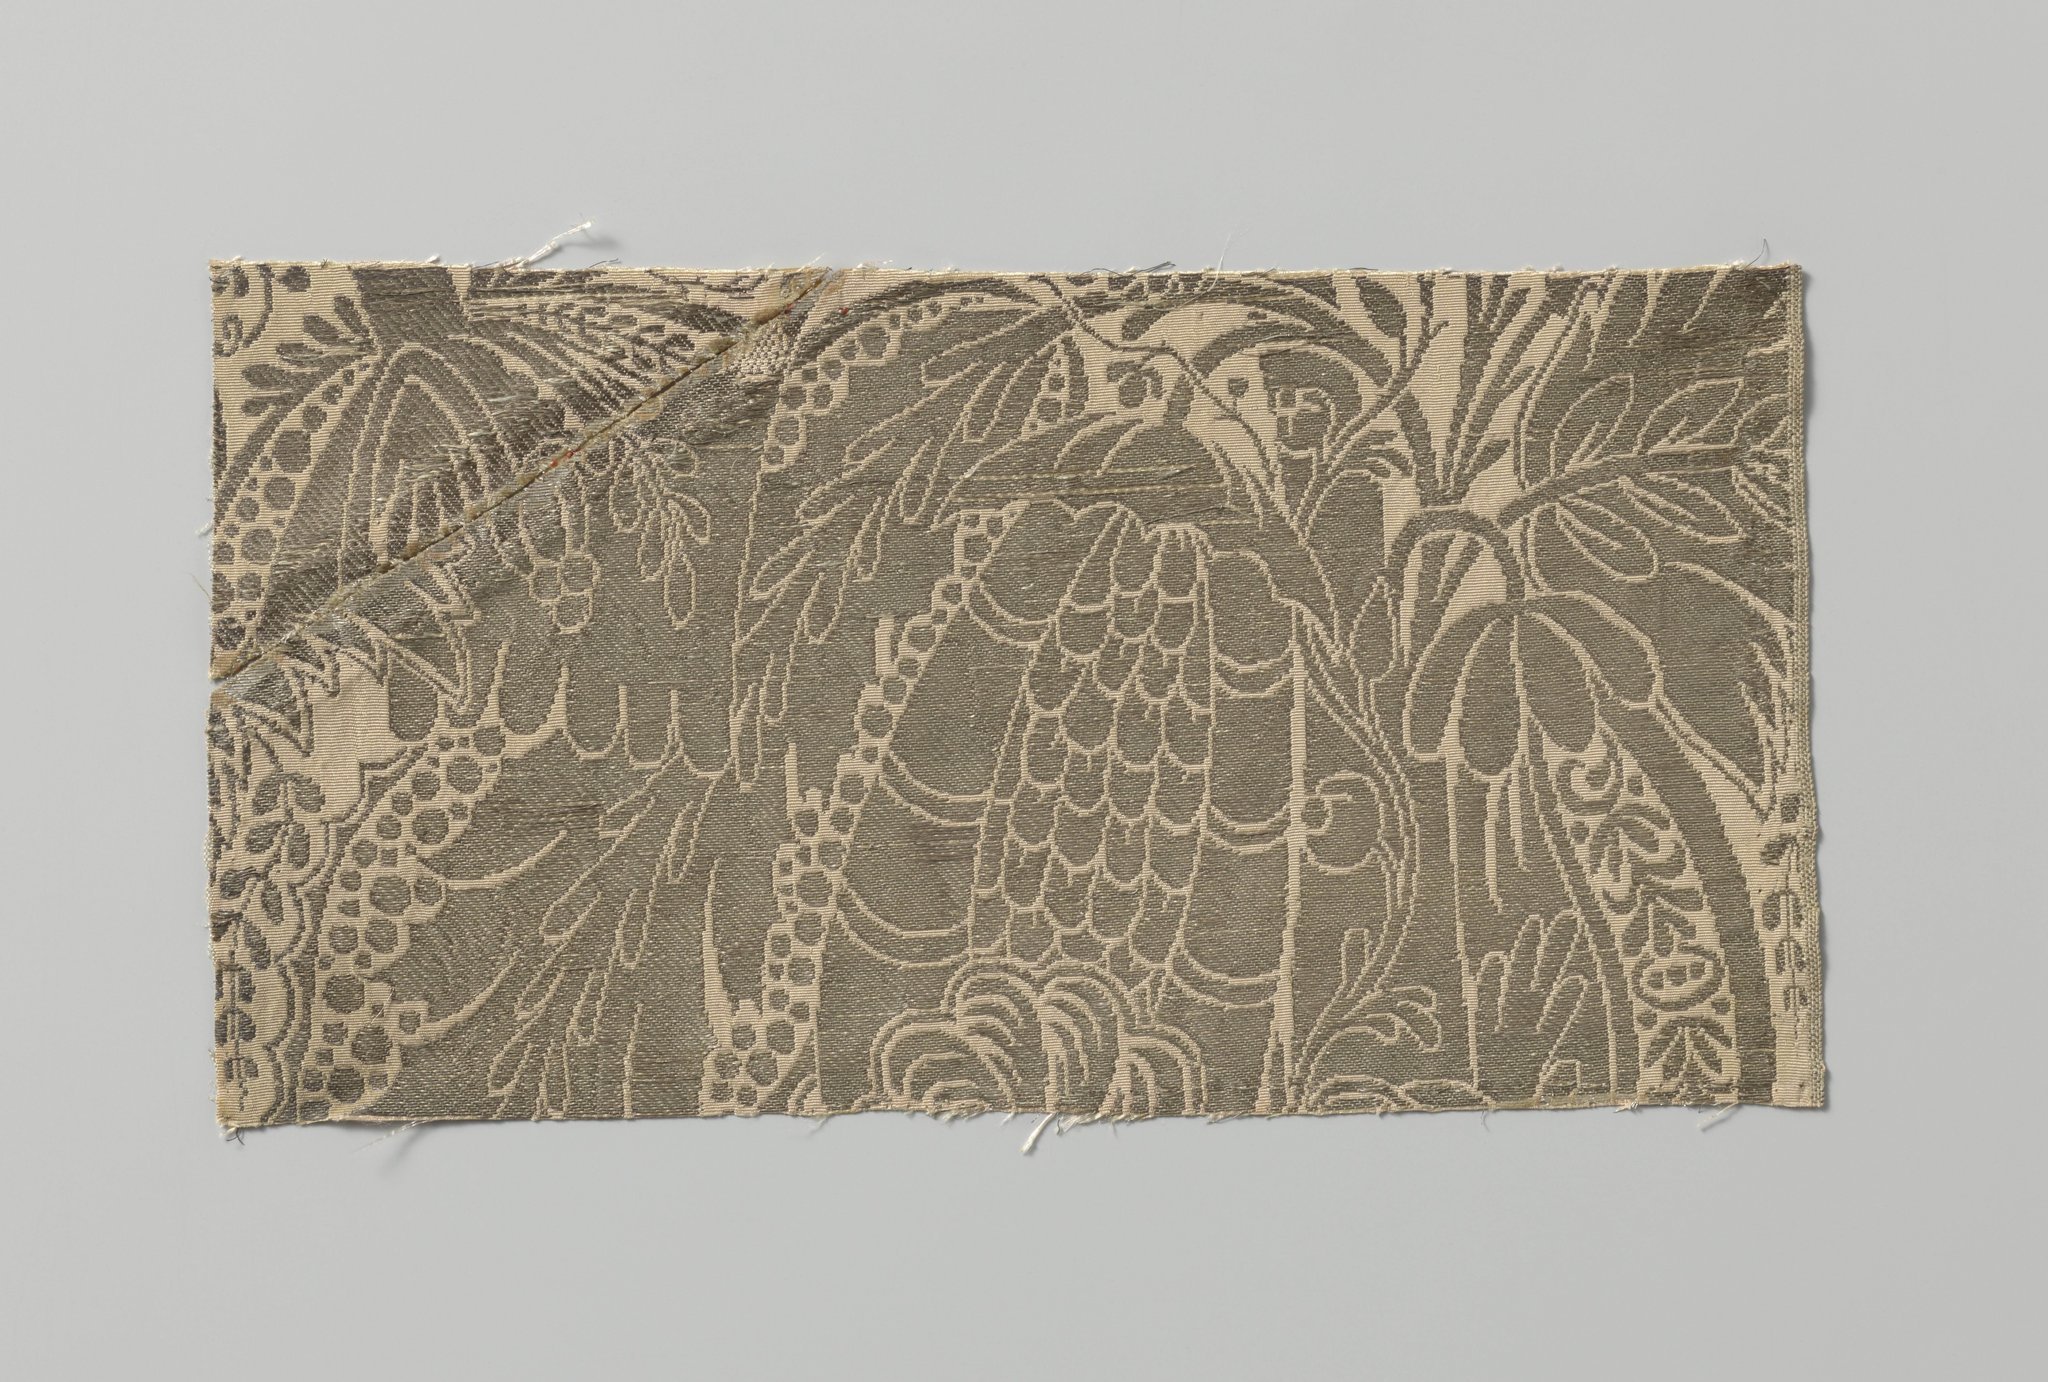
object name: fragment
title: Fragment bleekroze zijde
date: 1690-1710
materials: silk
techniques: launching, rib binding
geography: france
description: Fragment bleekrose zijde met in zilver patroon van bladeren, bloemen en vruchten.